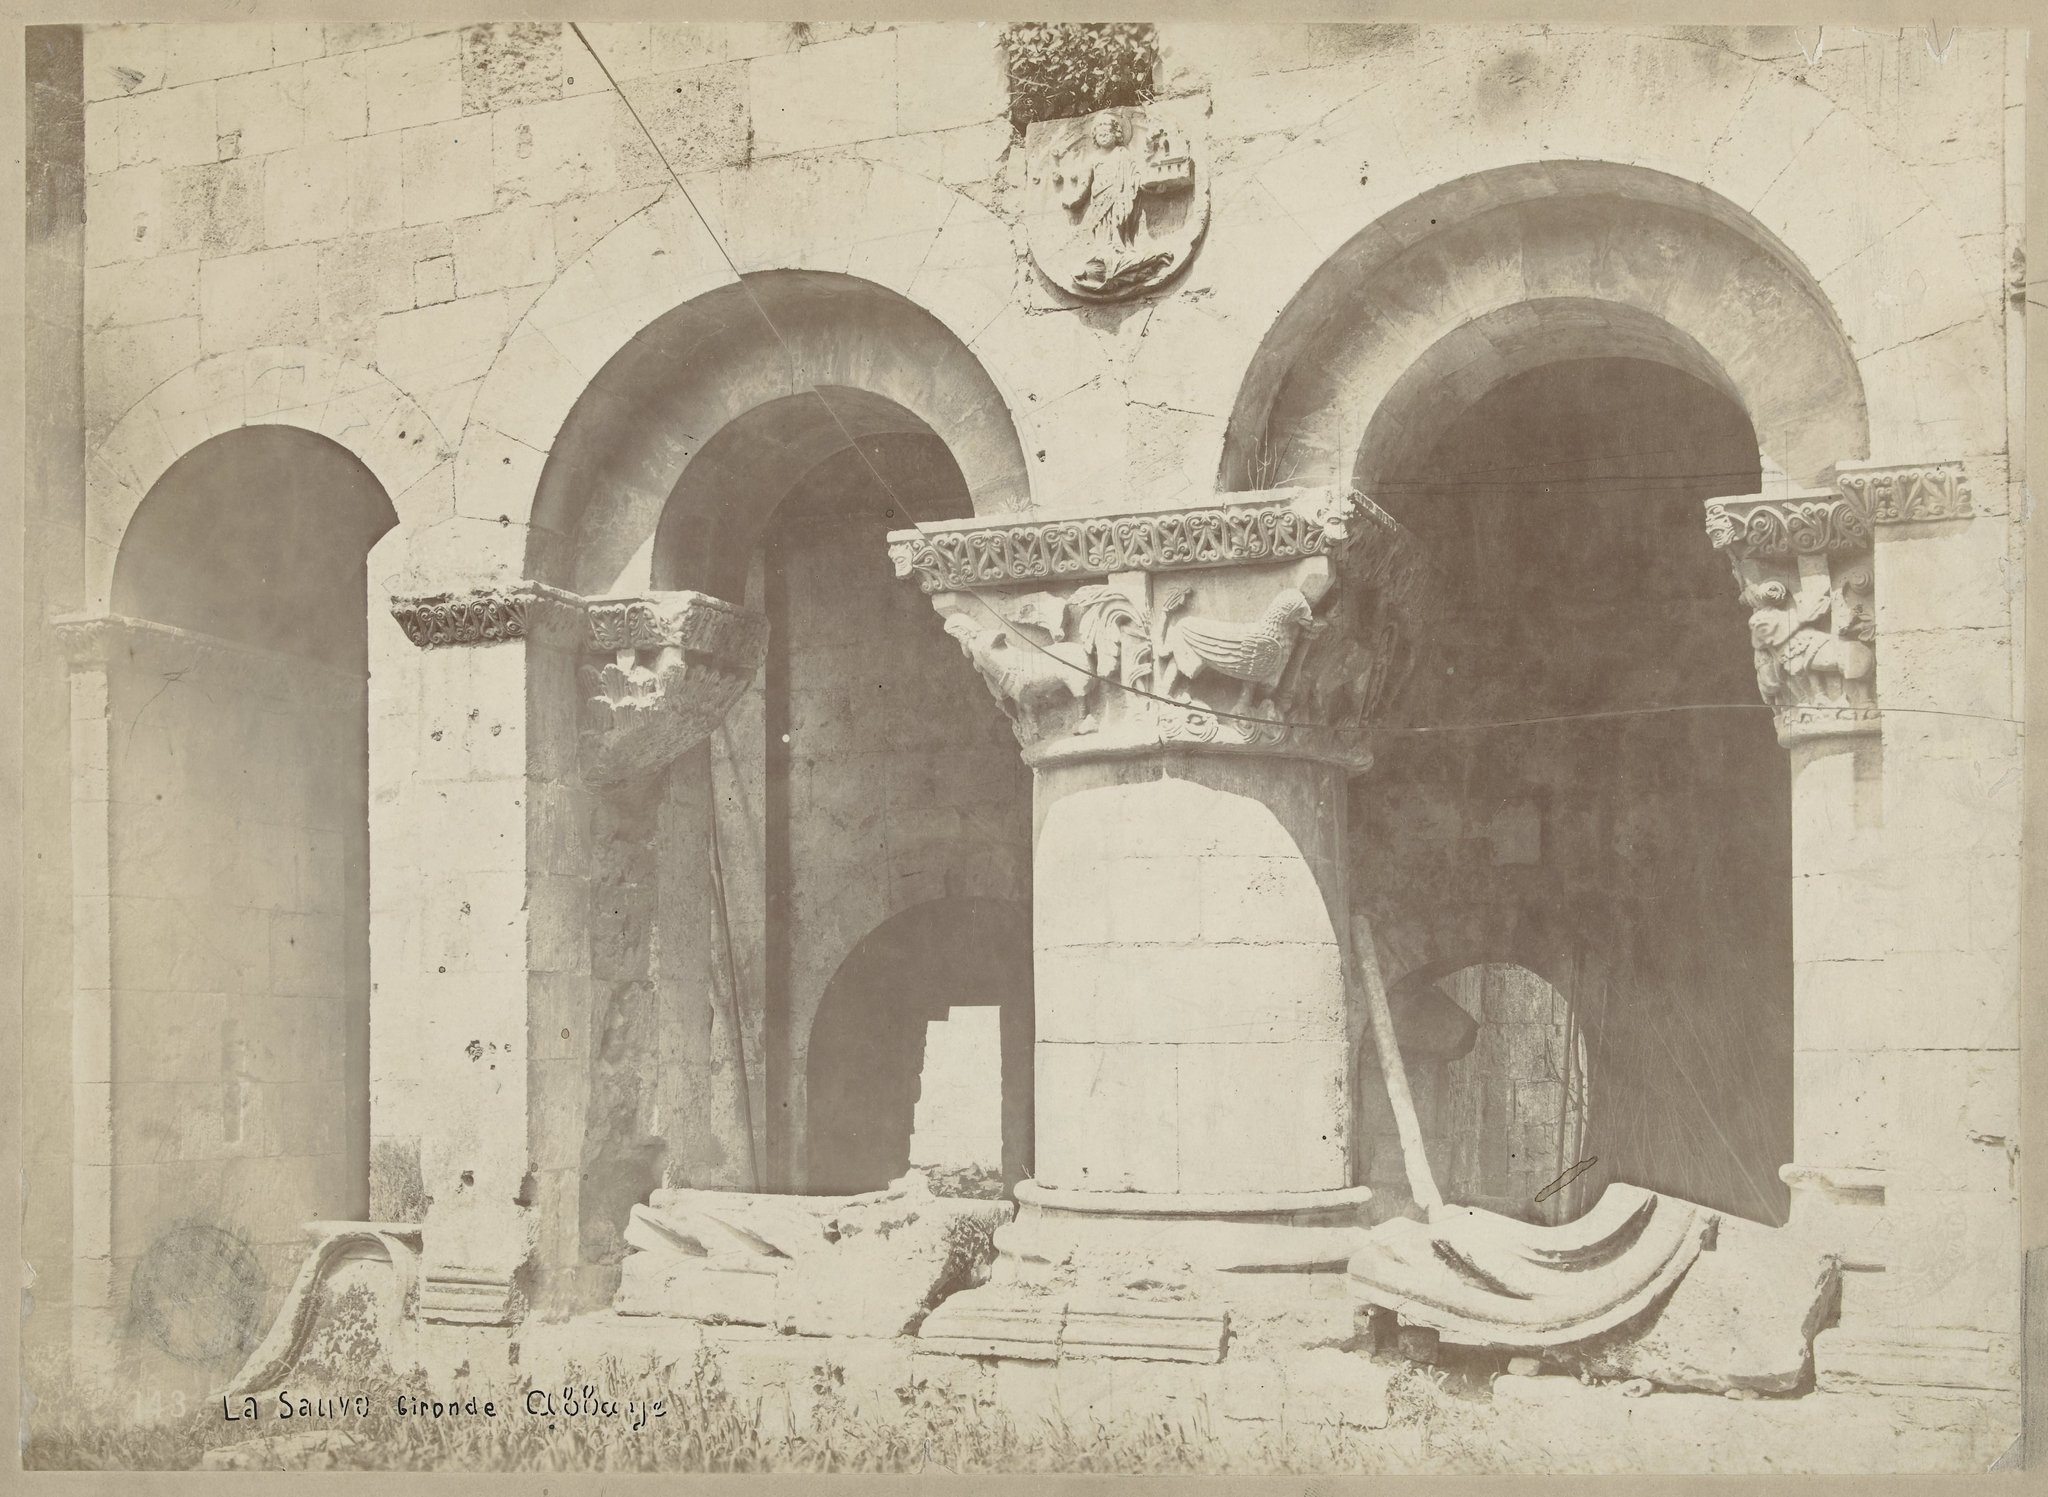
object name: photograph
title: La Sauve Gironde Abbaye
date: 1890-1900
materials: cardboard, paper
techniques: albumen print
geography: la sauve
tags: abbey, monastery, convent ~ roman catholic church, ruin of church, monastery, etc.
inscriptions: inscription, number: ‘143’, collector's mark: Lugt 3937, inscription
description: Het negatief dat gebruikt is voor deze afdruk is gebroken.